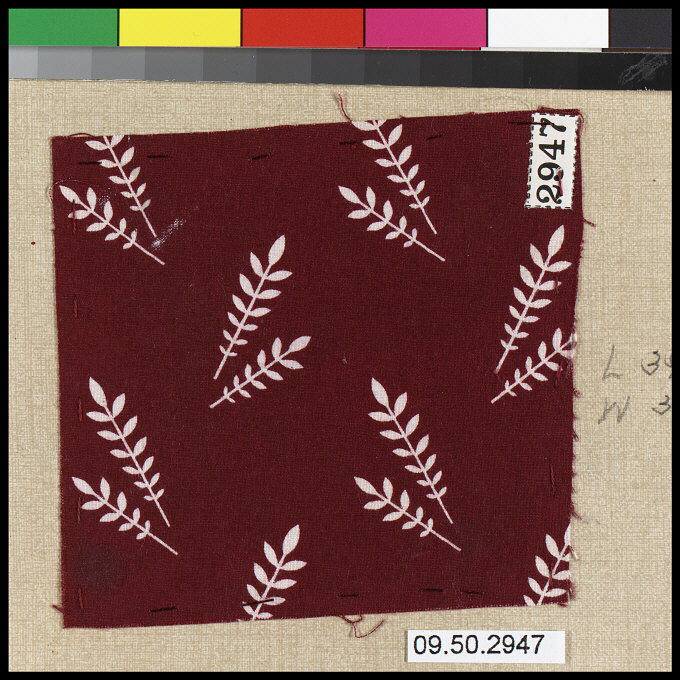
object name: piece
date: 1801-1900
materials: cotton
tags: leaves